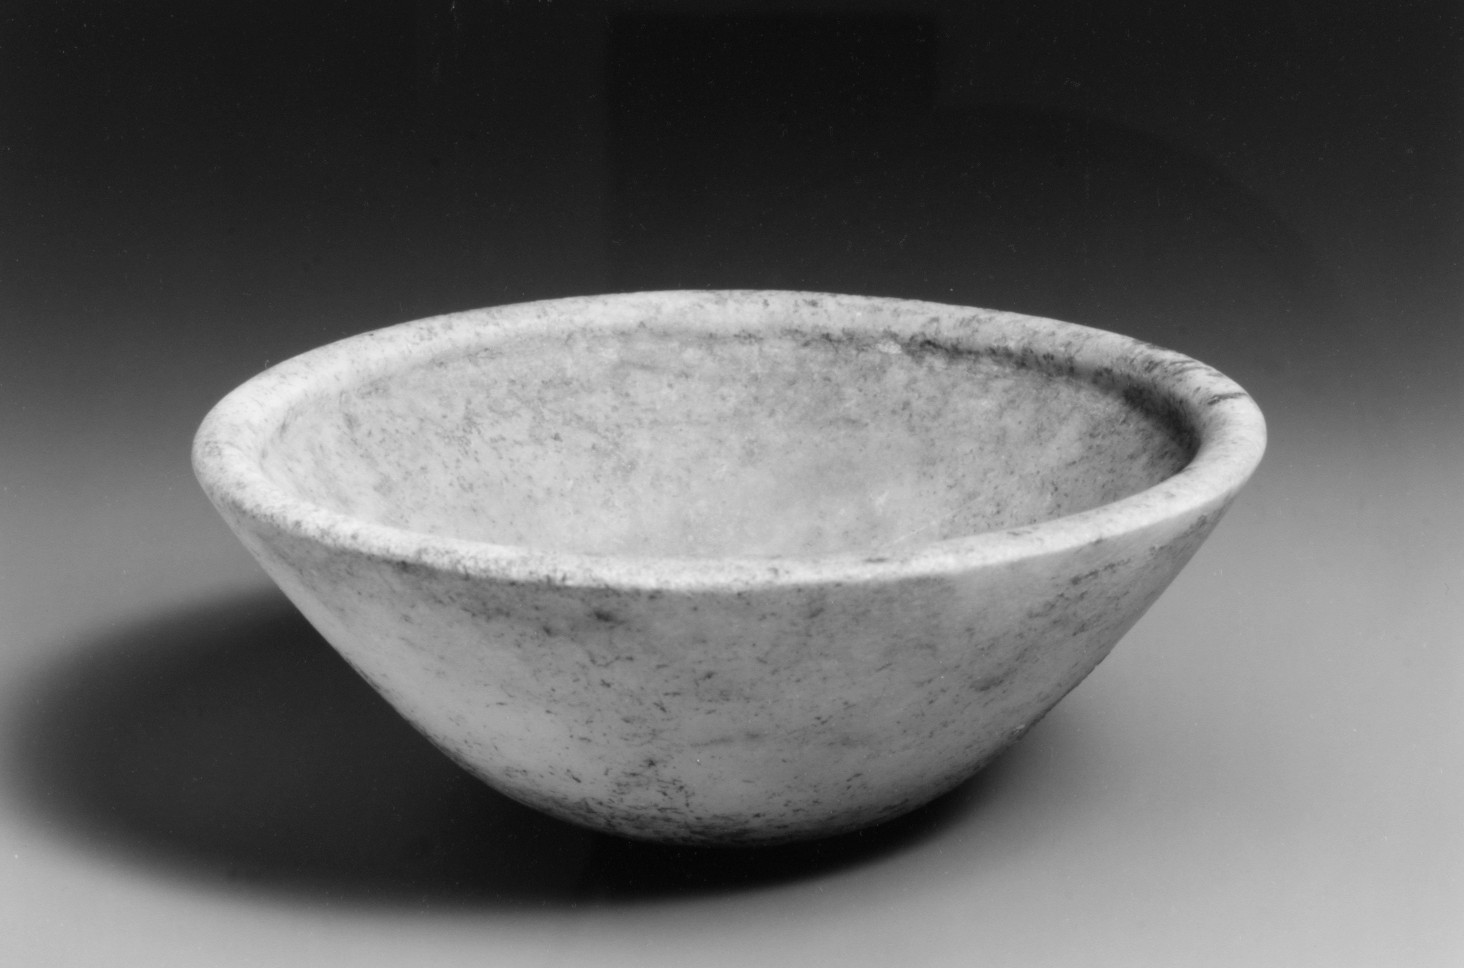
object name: bowl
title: Marble bowl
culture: cycladic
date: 2700-2400 BCE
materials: marble